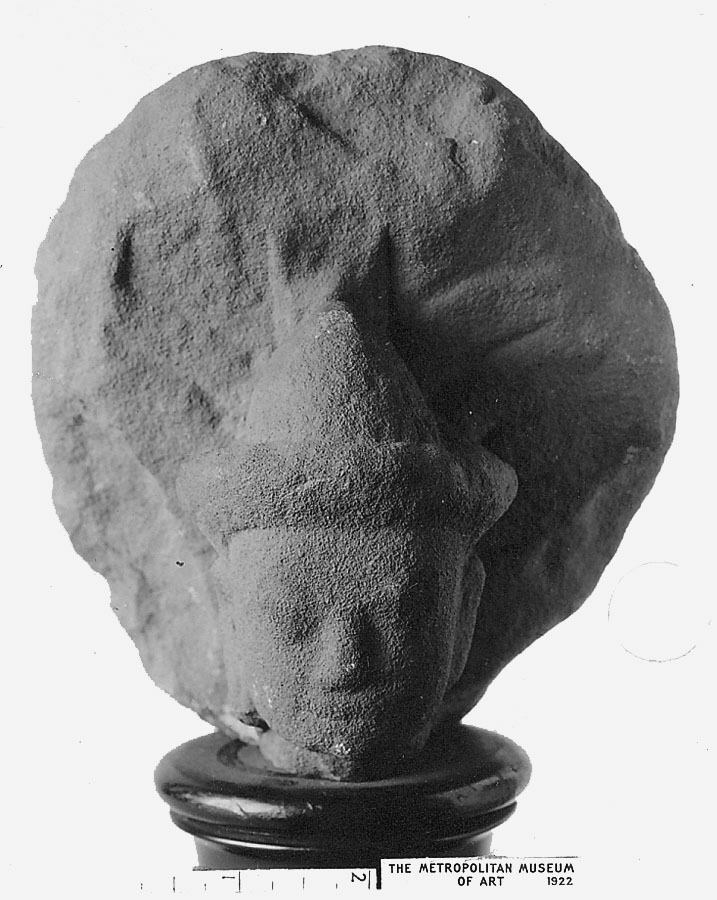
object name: head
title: Head of a Buddha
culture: cambodian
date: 900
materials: stone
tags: heads,buddhism,buddha